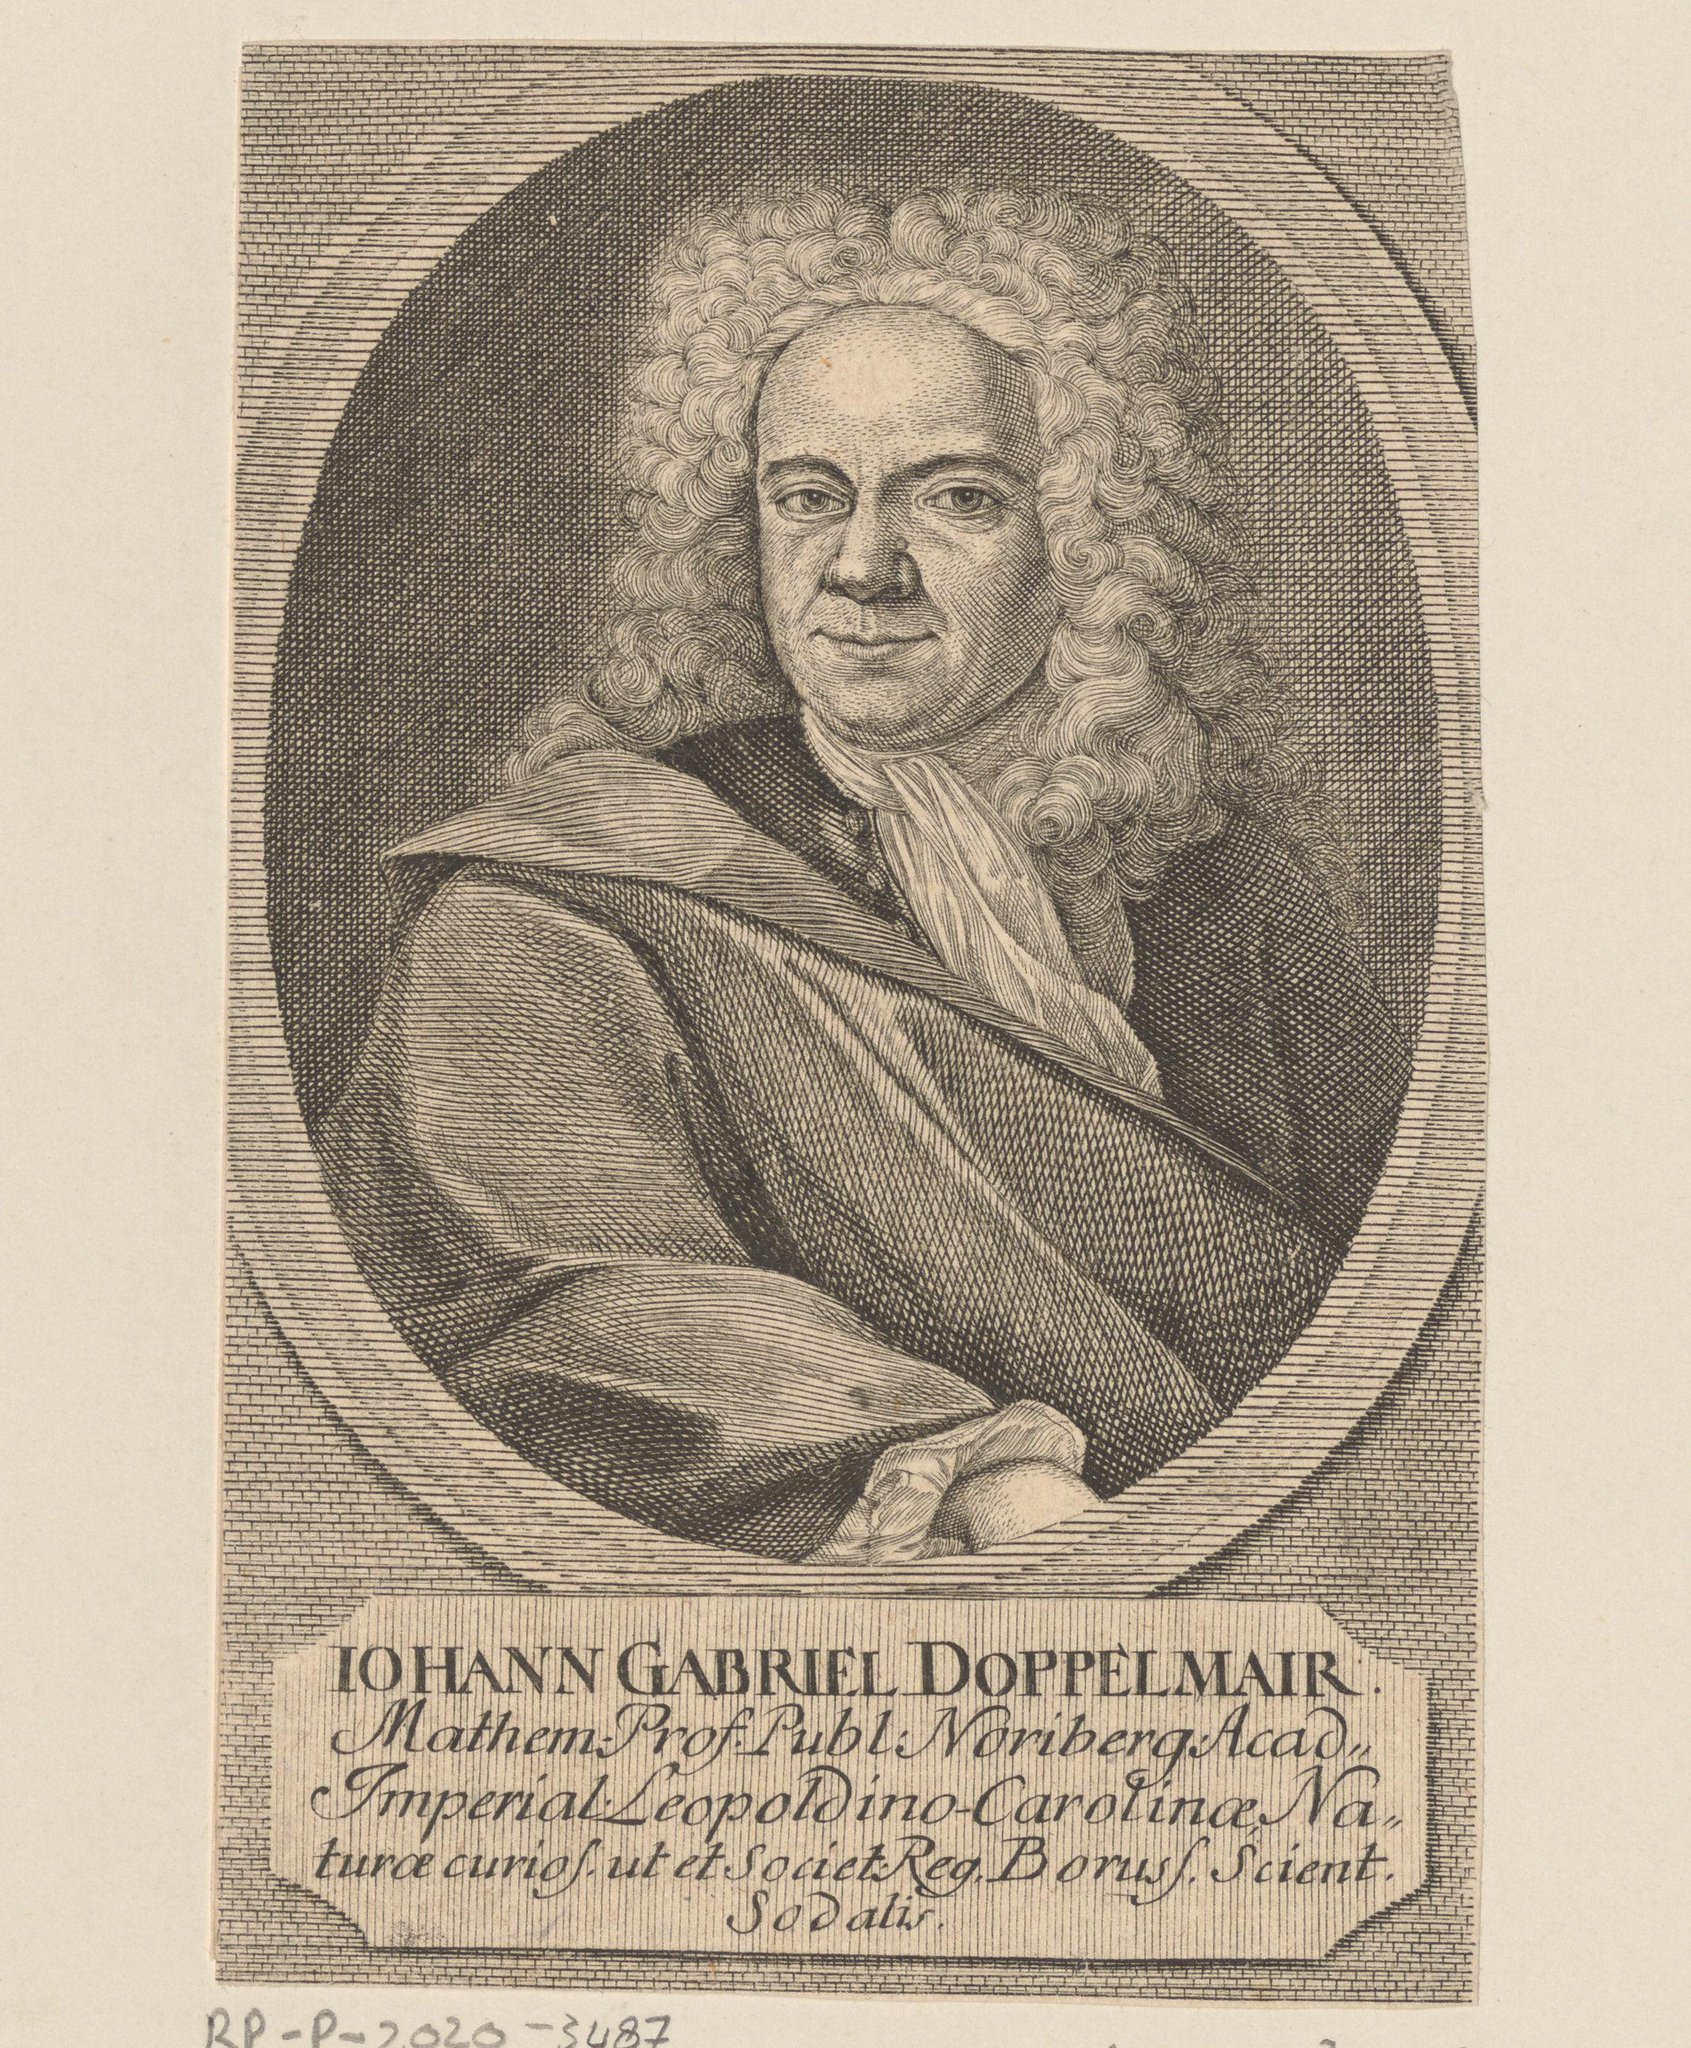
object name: print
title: Portret van Johann Gabriel Doppelmayr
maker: Anonymous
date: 1727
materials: paper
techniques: engraving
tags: historical persons, astronomy (and cosmography)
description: Prent mogelijk uit: Fränckische acta erudita et curiosa (...). Neurenberg: Julius Arnold Engelbrecht, 1727, dl. 6.